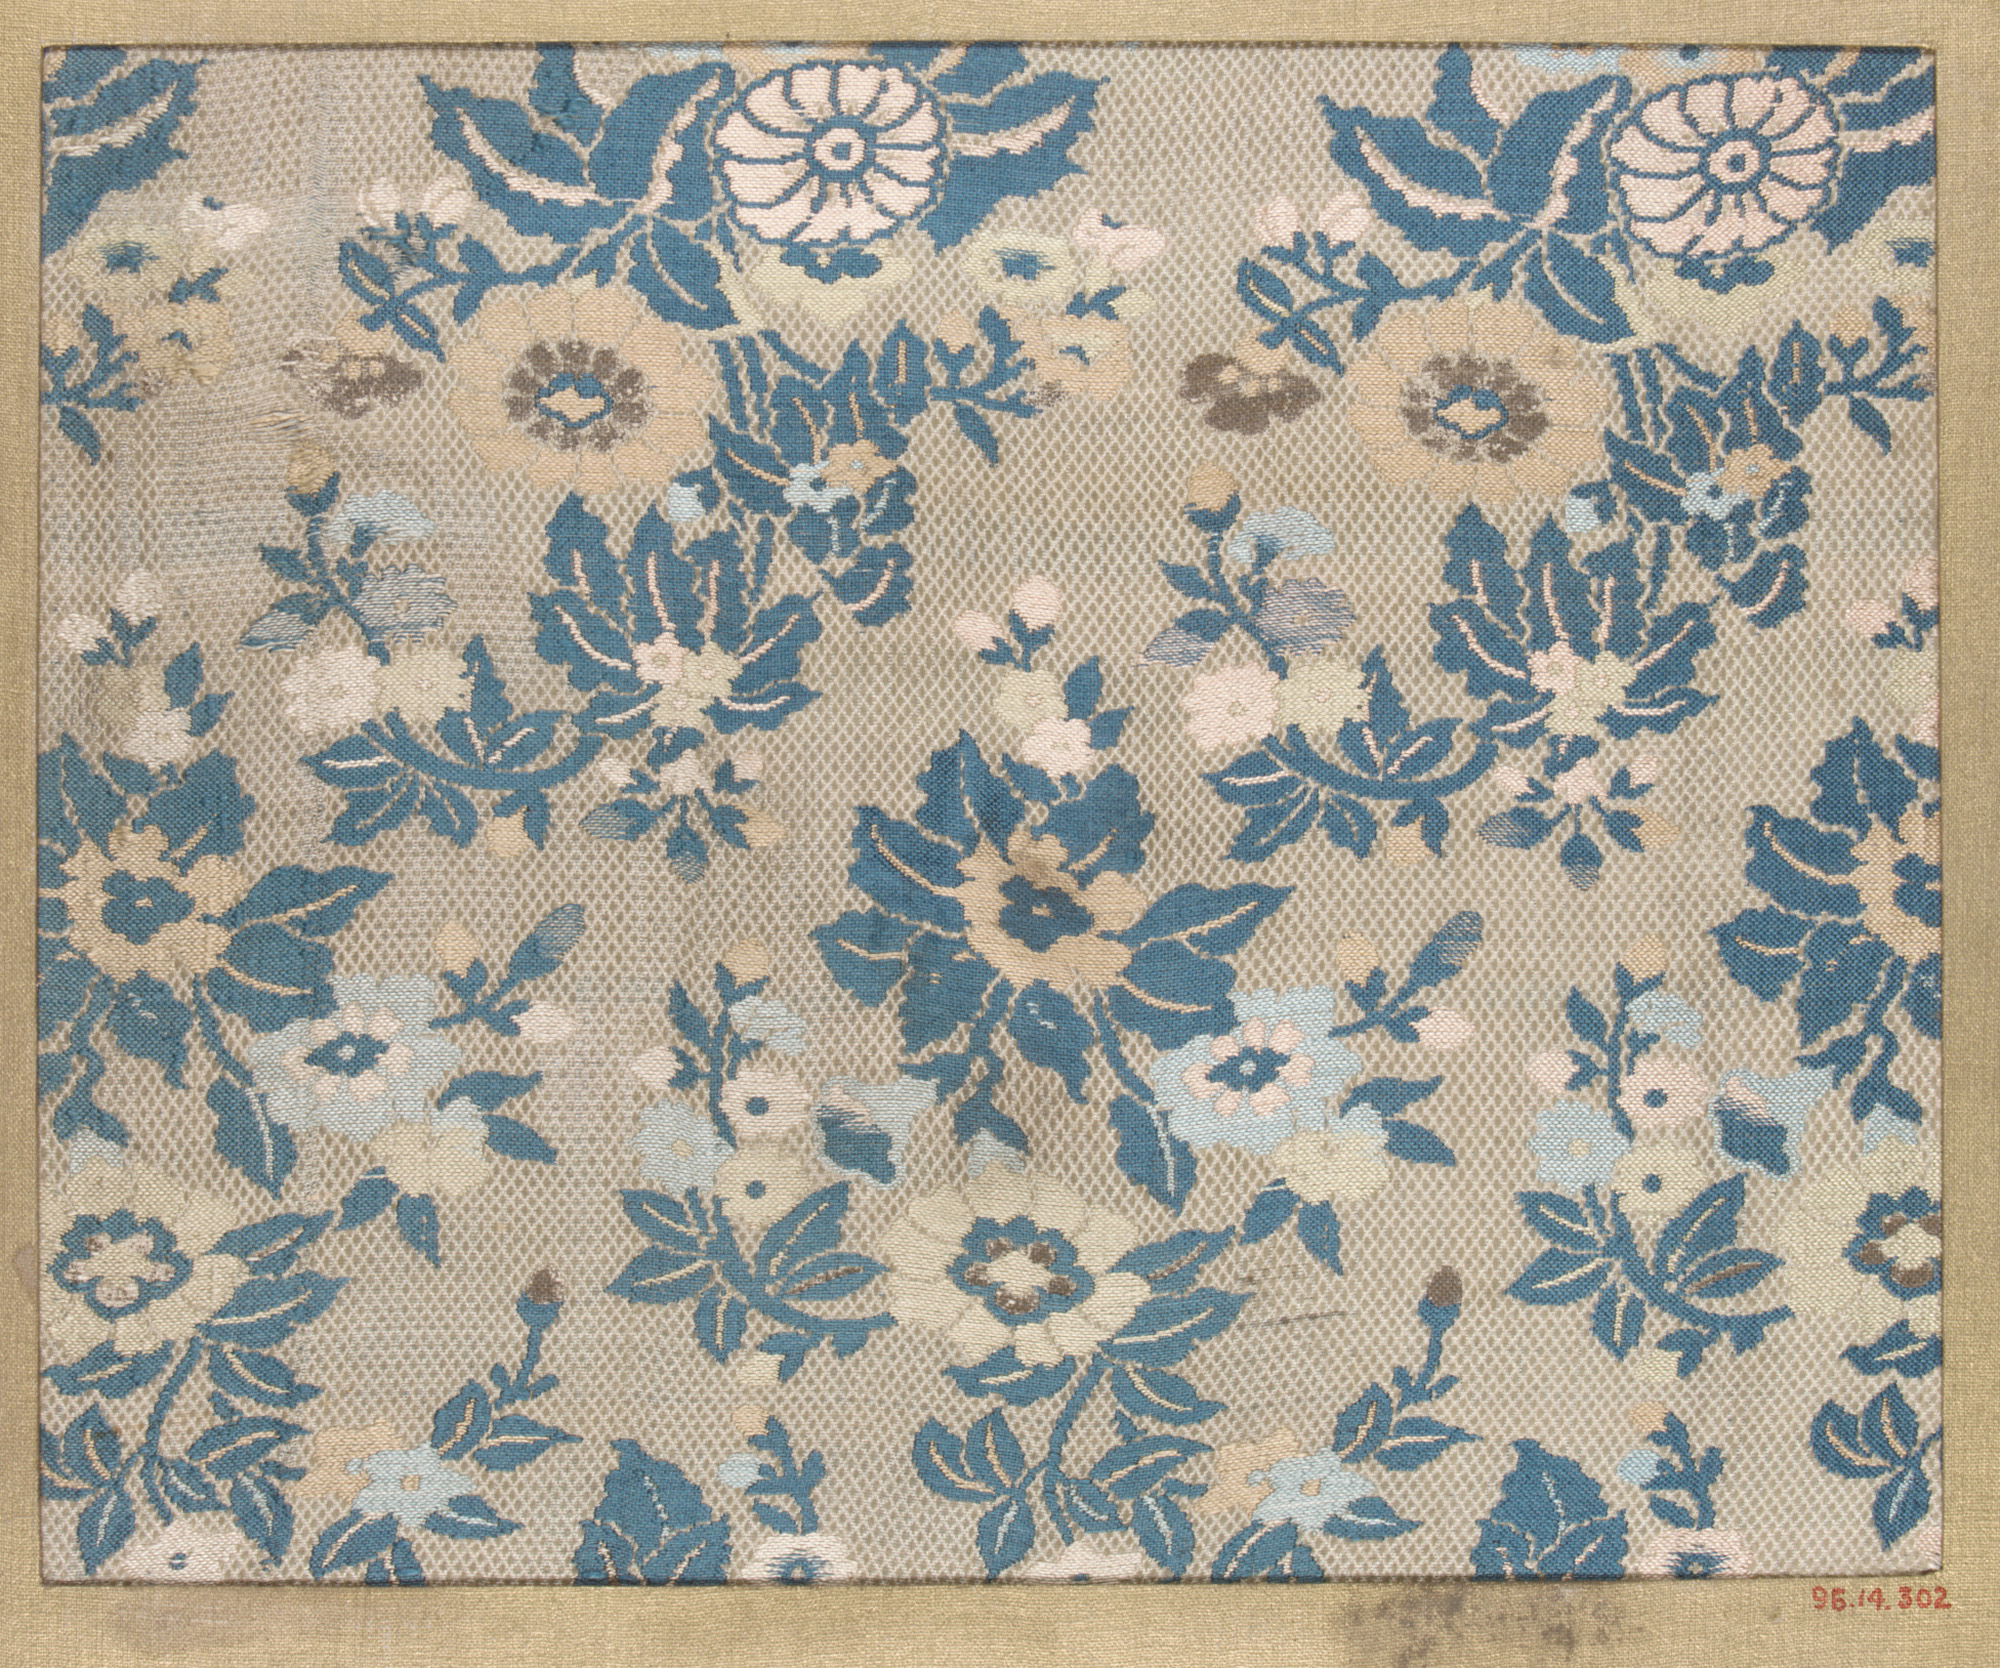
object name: piece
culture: japanese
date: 1701-1900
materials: silk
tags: leaves